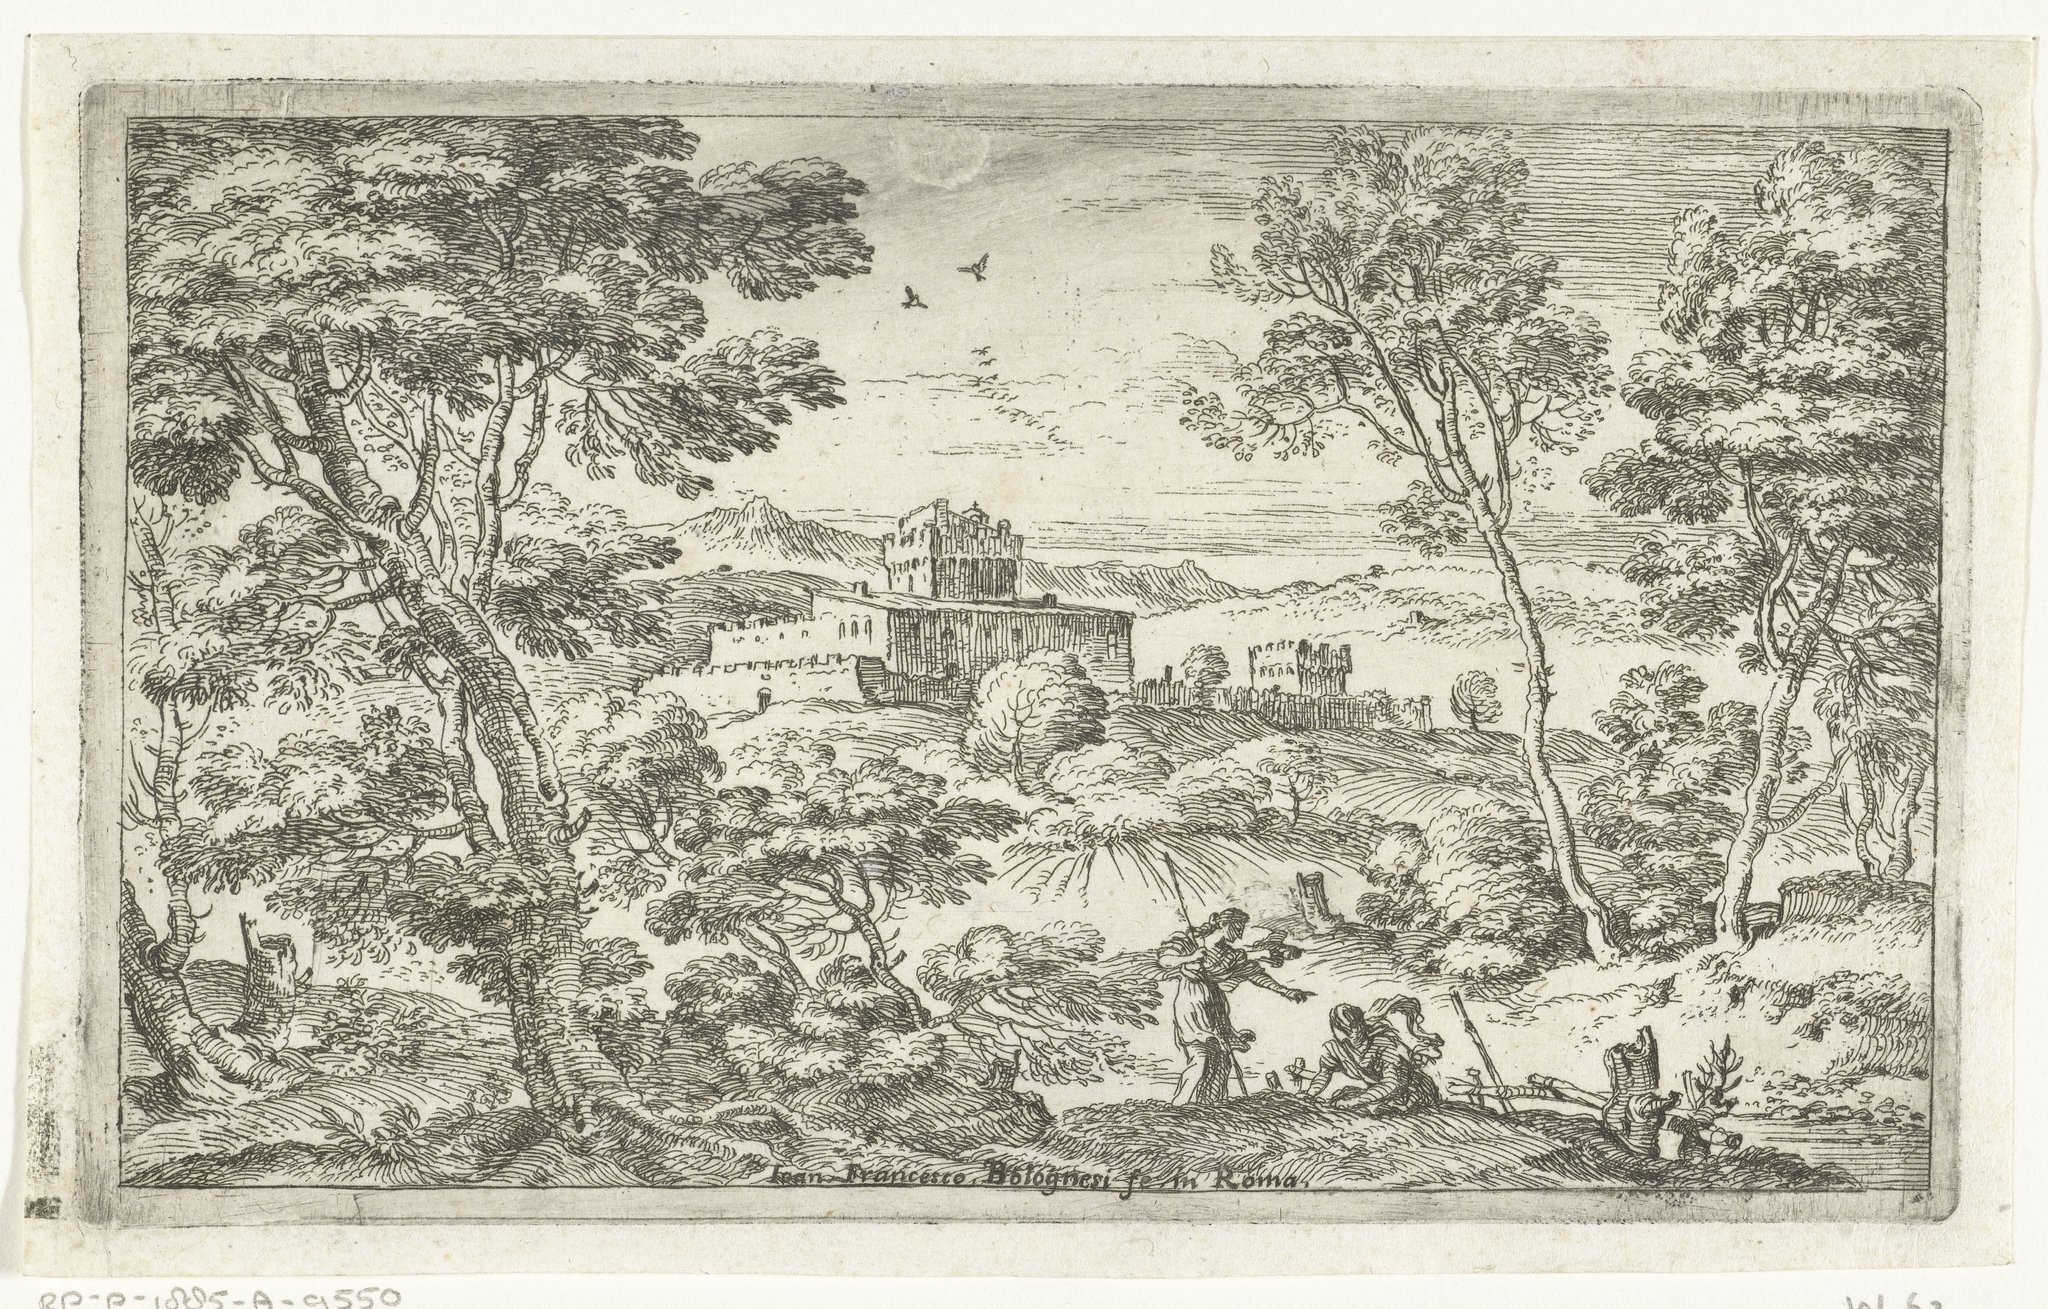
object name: print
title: Landschap met staande en zittende vrouw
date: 1616-1680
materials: paper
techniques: etching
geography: rome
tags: herding, herdsman, herdswoman, shepherd, shepherdess, cowherd, etc., landscape with tower or castle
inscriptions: collector's mark: Lugt 2228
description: Landschap met op de voorgrond een staande vrouw met lange stok in rechter hand, wijzend naar voorover gebogen zittende vrouw. Op de achtergrond een kasteel.